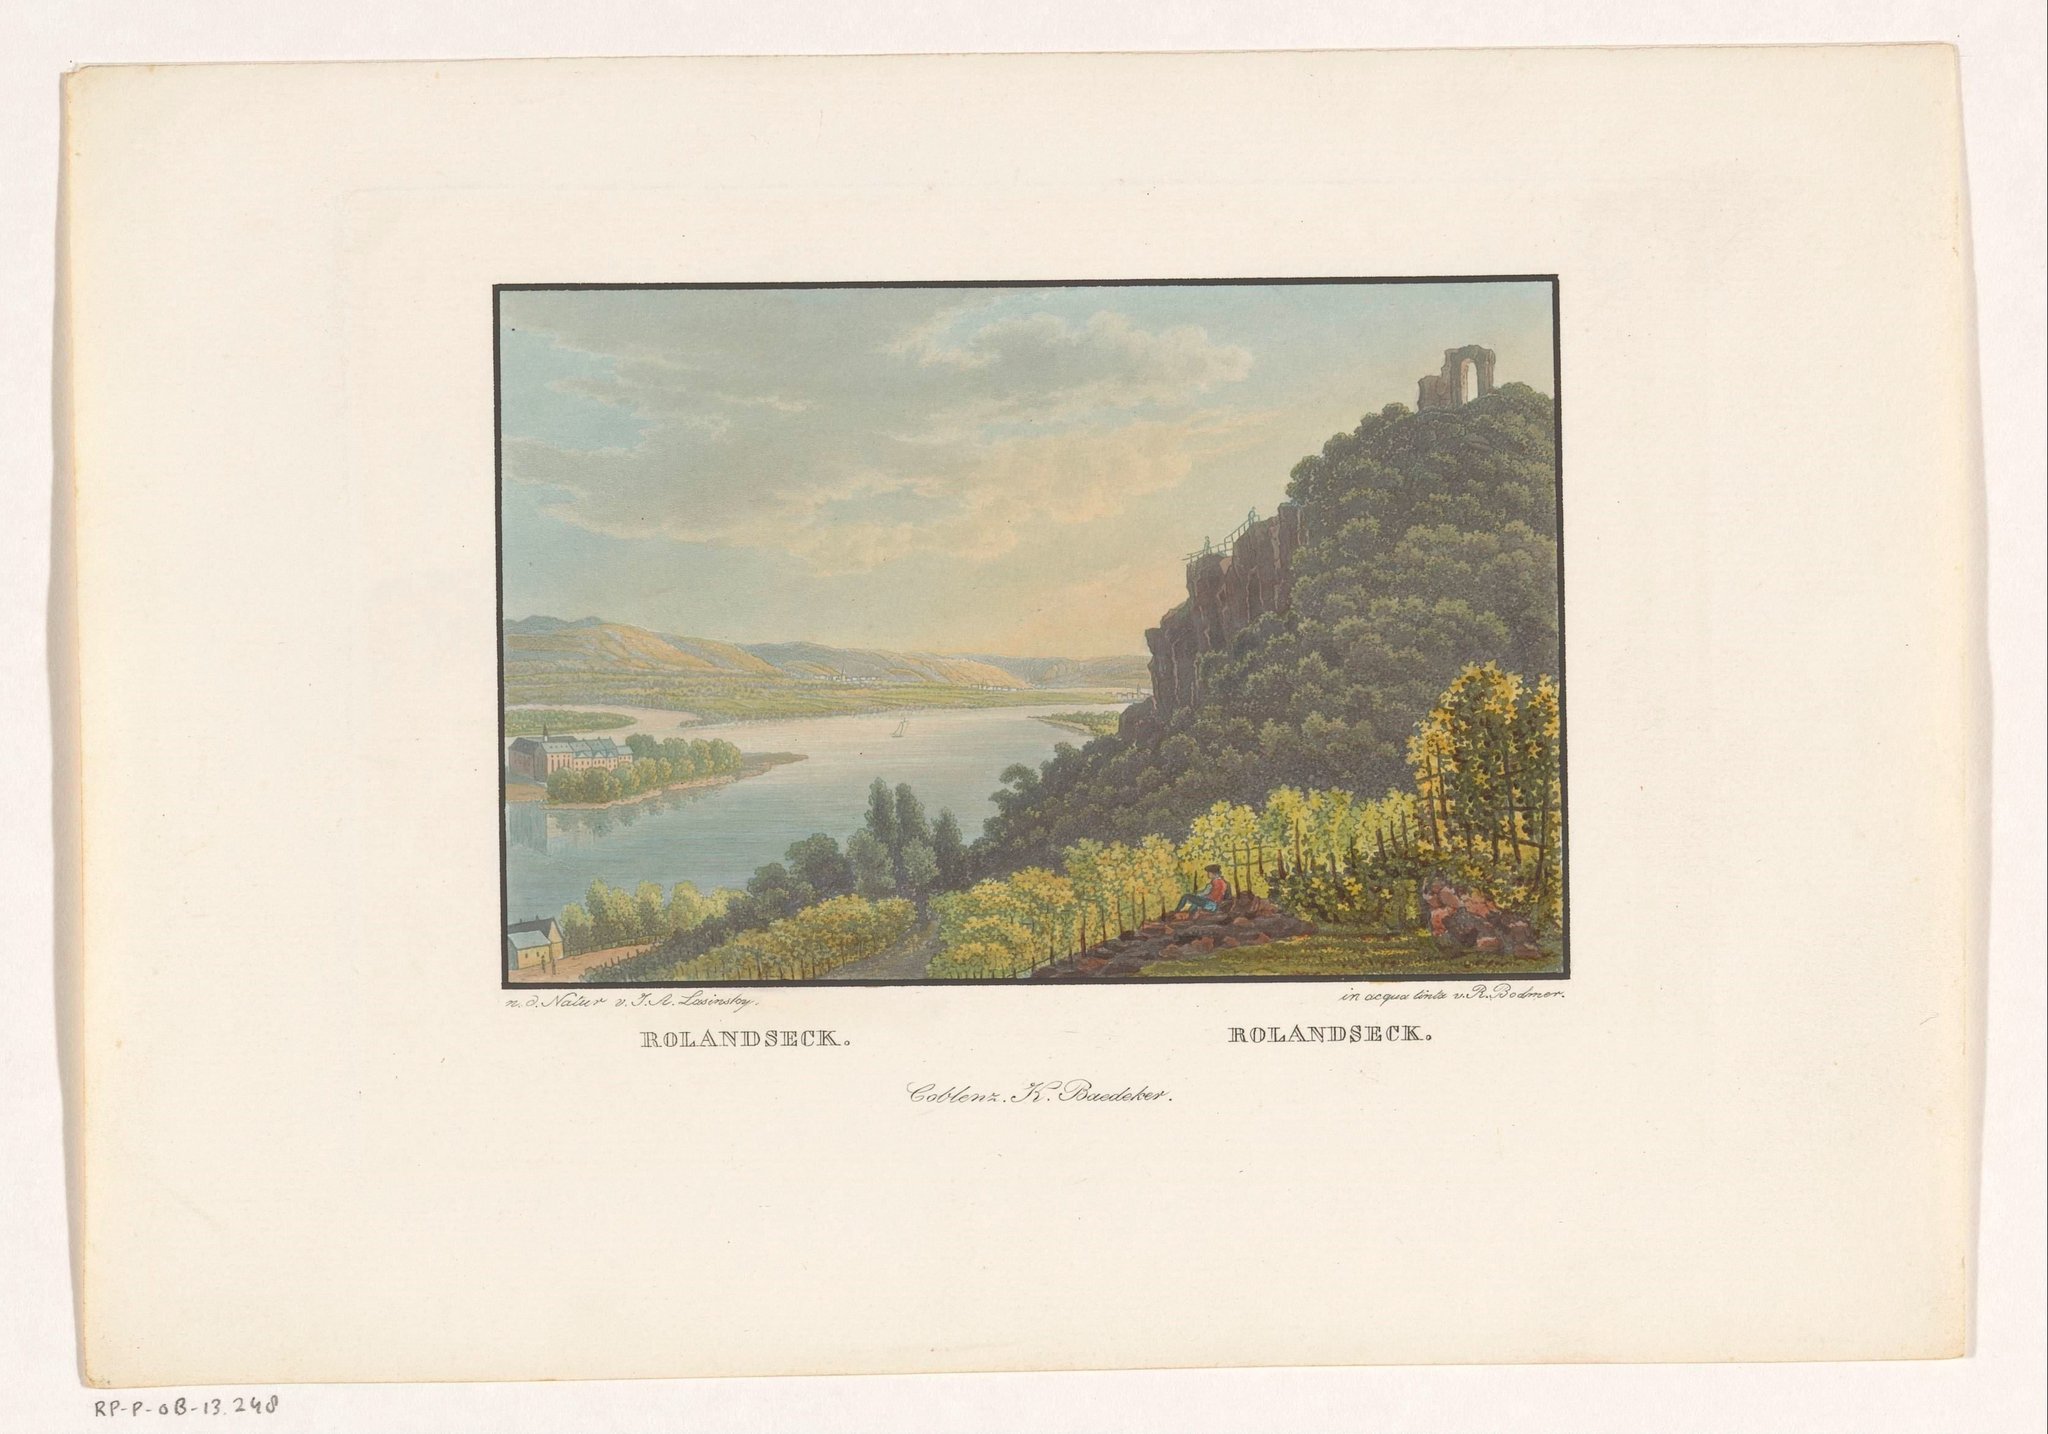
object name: print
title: Gezicht op Rolandseck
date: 1832-1872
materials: paper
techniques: hand coloring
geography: koblenz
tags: river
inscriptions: collector's mark: Lugt 2228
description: Vanaf 1828 verschenen bij Franz Friedrich Röhling in Koblenz verschillende uitgaven met prenten van burchten en kastelen gelegen langs de Rijn, vervaardigd door Rudolf Bodmer naar tekeningen van Adolf Lasinsky. Vanaf 1832 verschenen deze publicaties bij Karl Baedeker, die het fonds van Röhling had overgenomen.